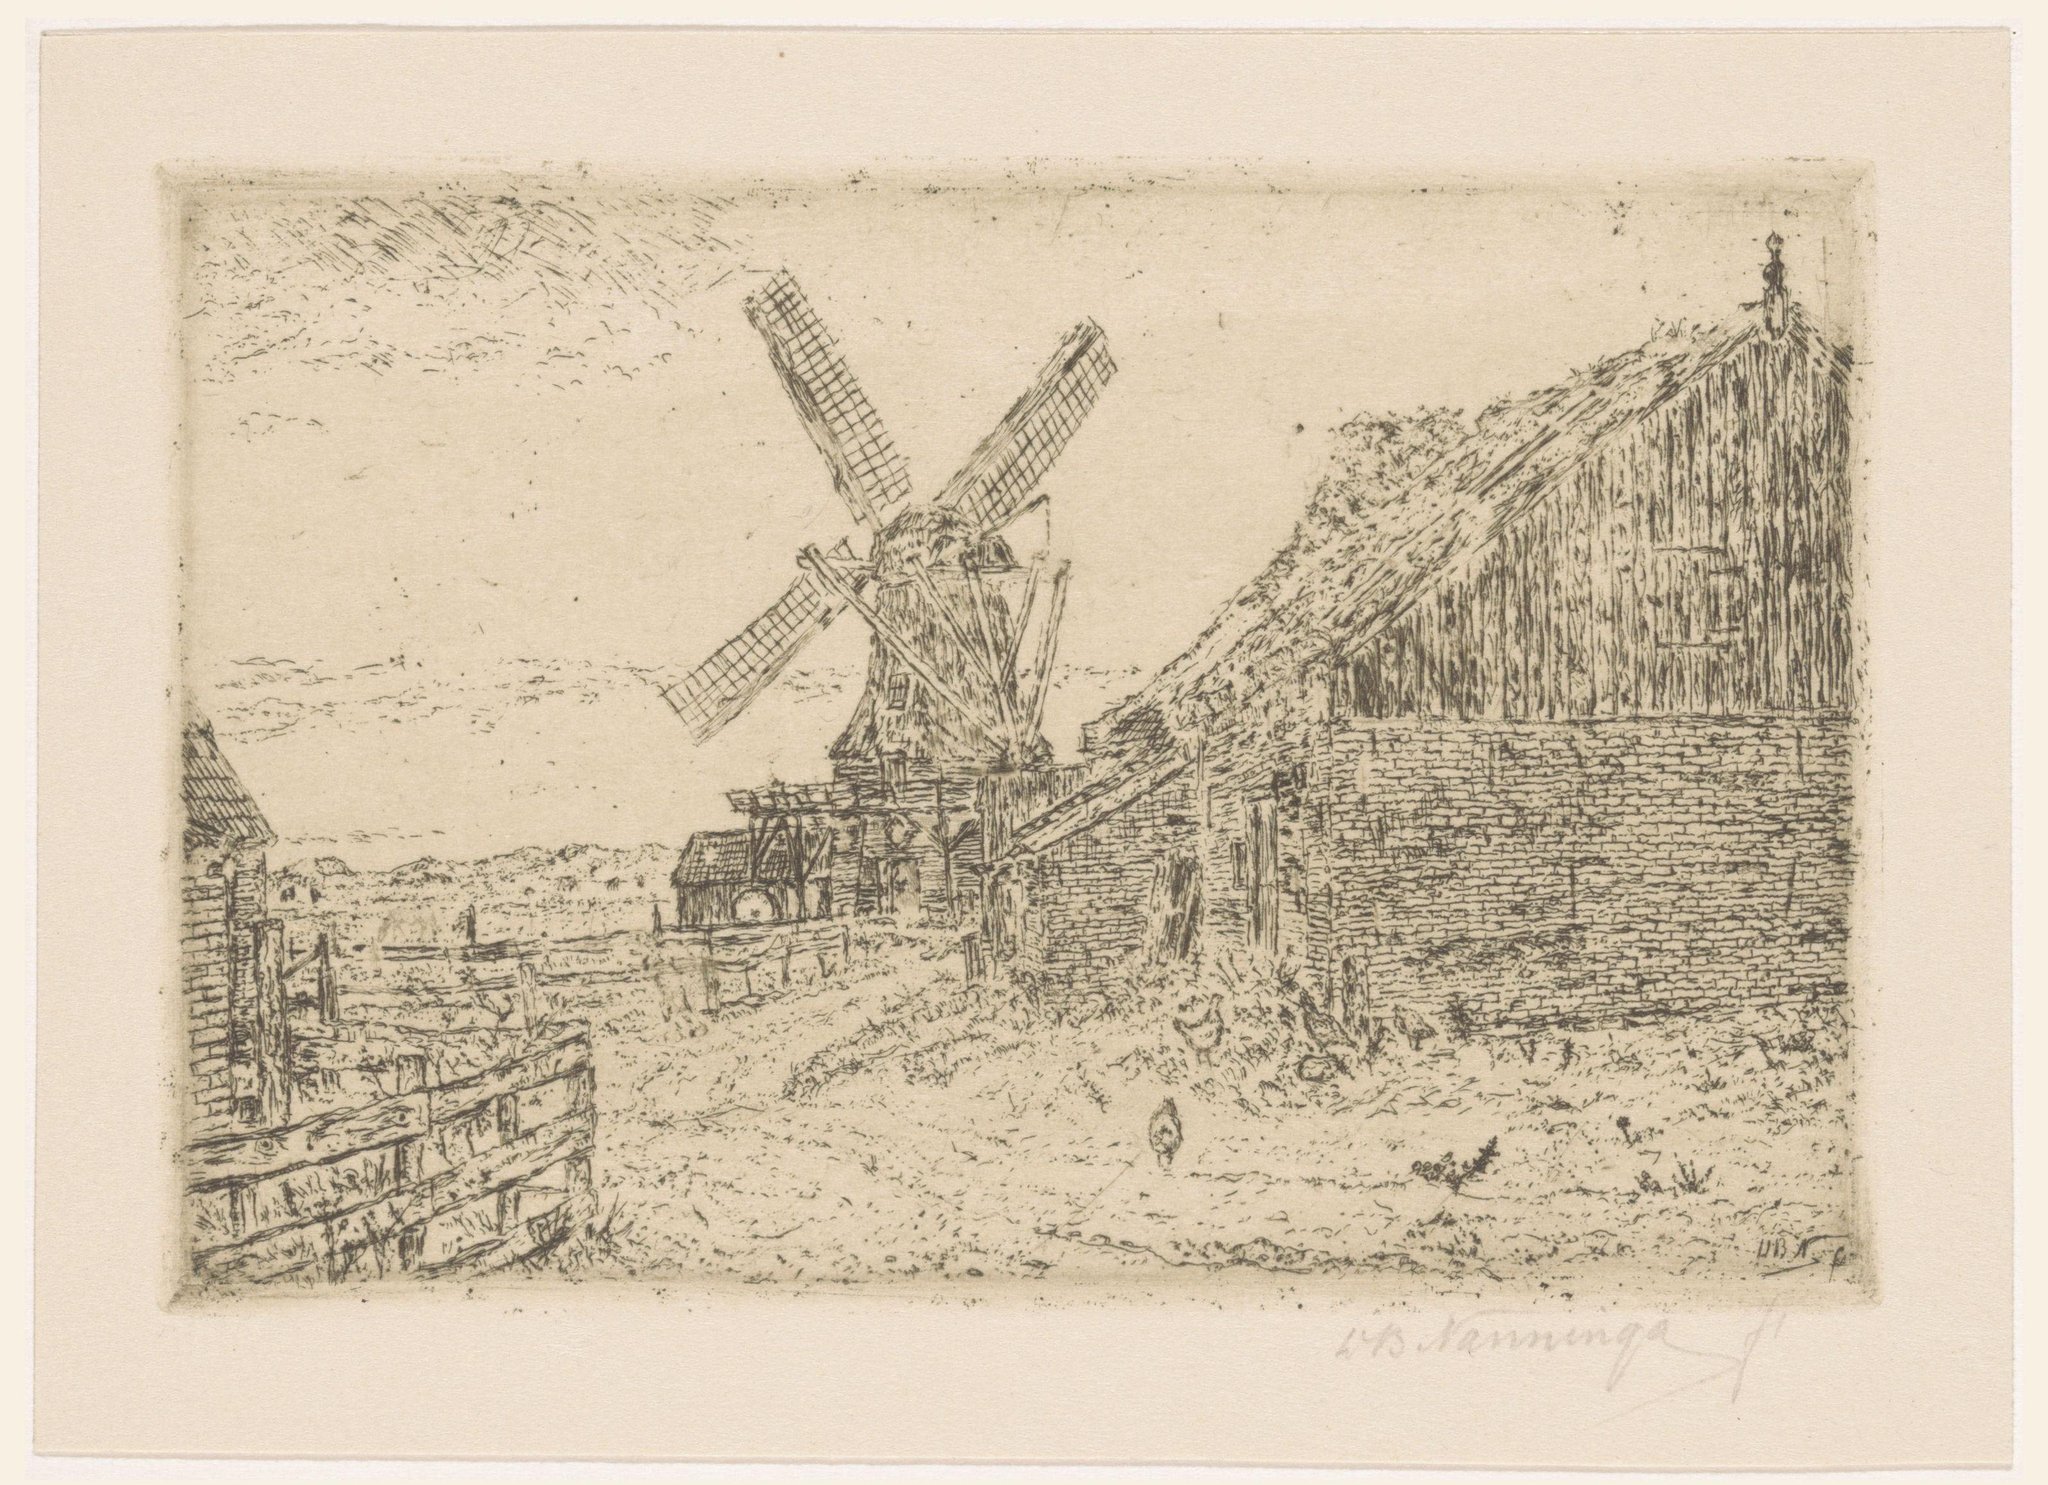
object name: print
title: Molen bij boerderij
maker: dirk berend nanninga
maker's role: print maker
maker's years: 1868-1954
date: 1878-1931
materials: paper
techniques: etching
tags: windmill in landscape, farm (building)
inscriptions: collector's mark: Lugt 2228